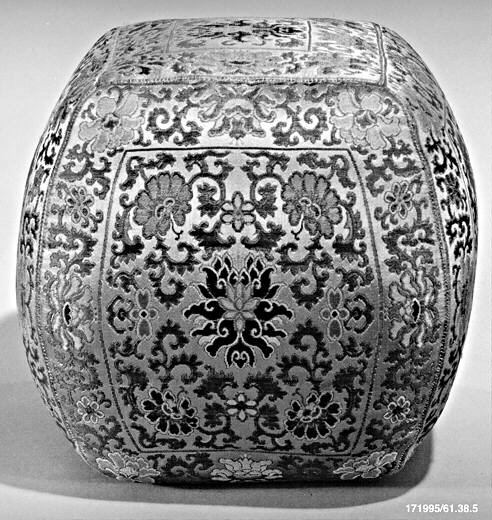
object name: cushion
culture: chinese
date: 1867-1900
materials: silk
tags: flowers